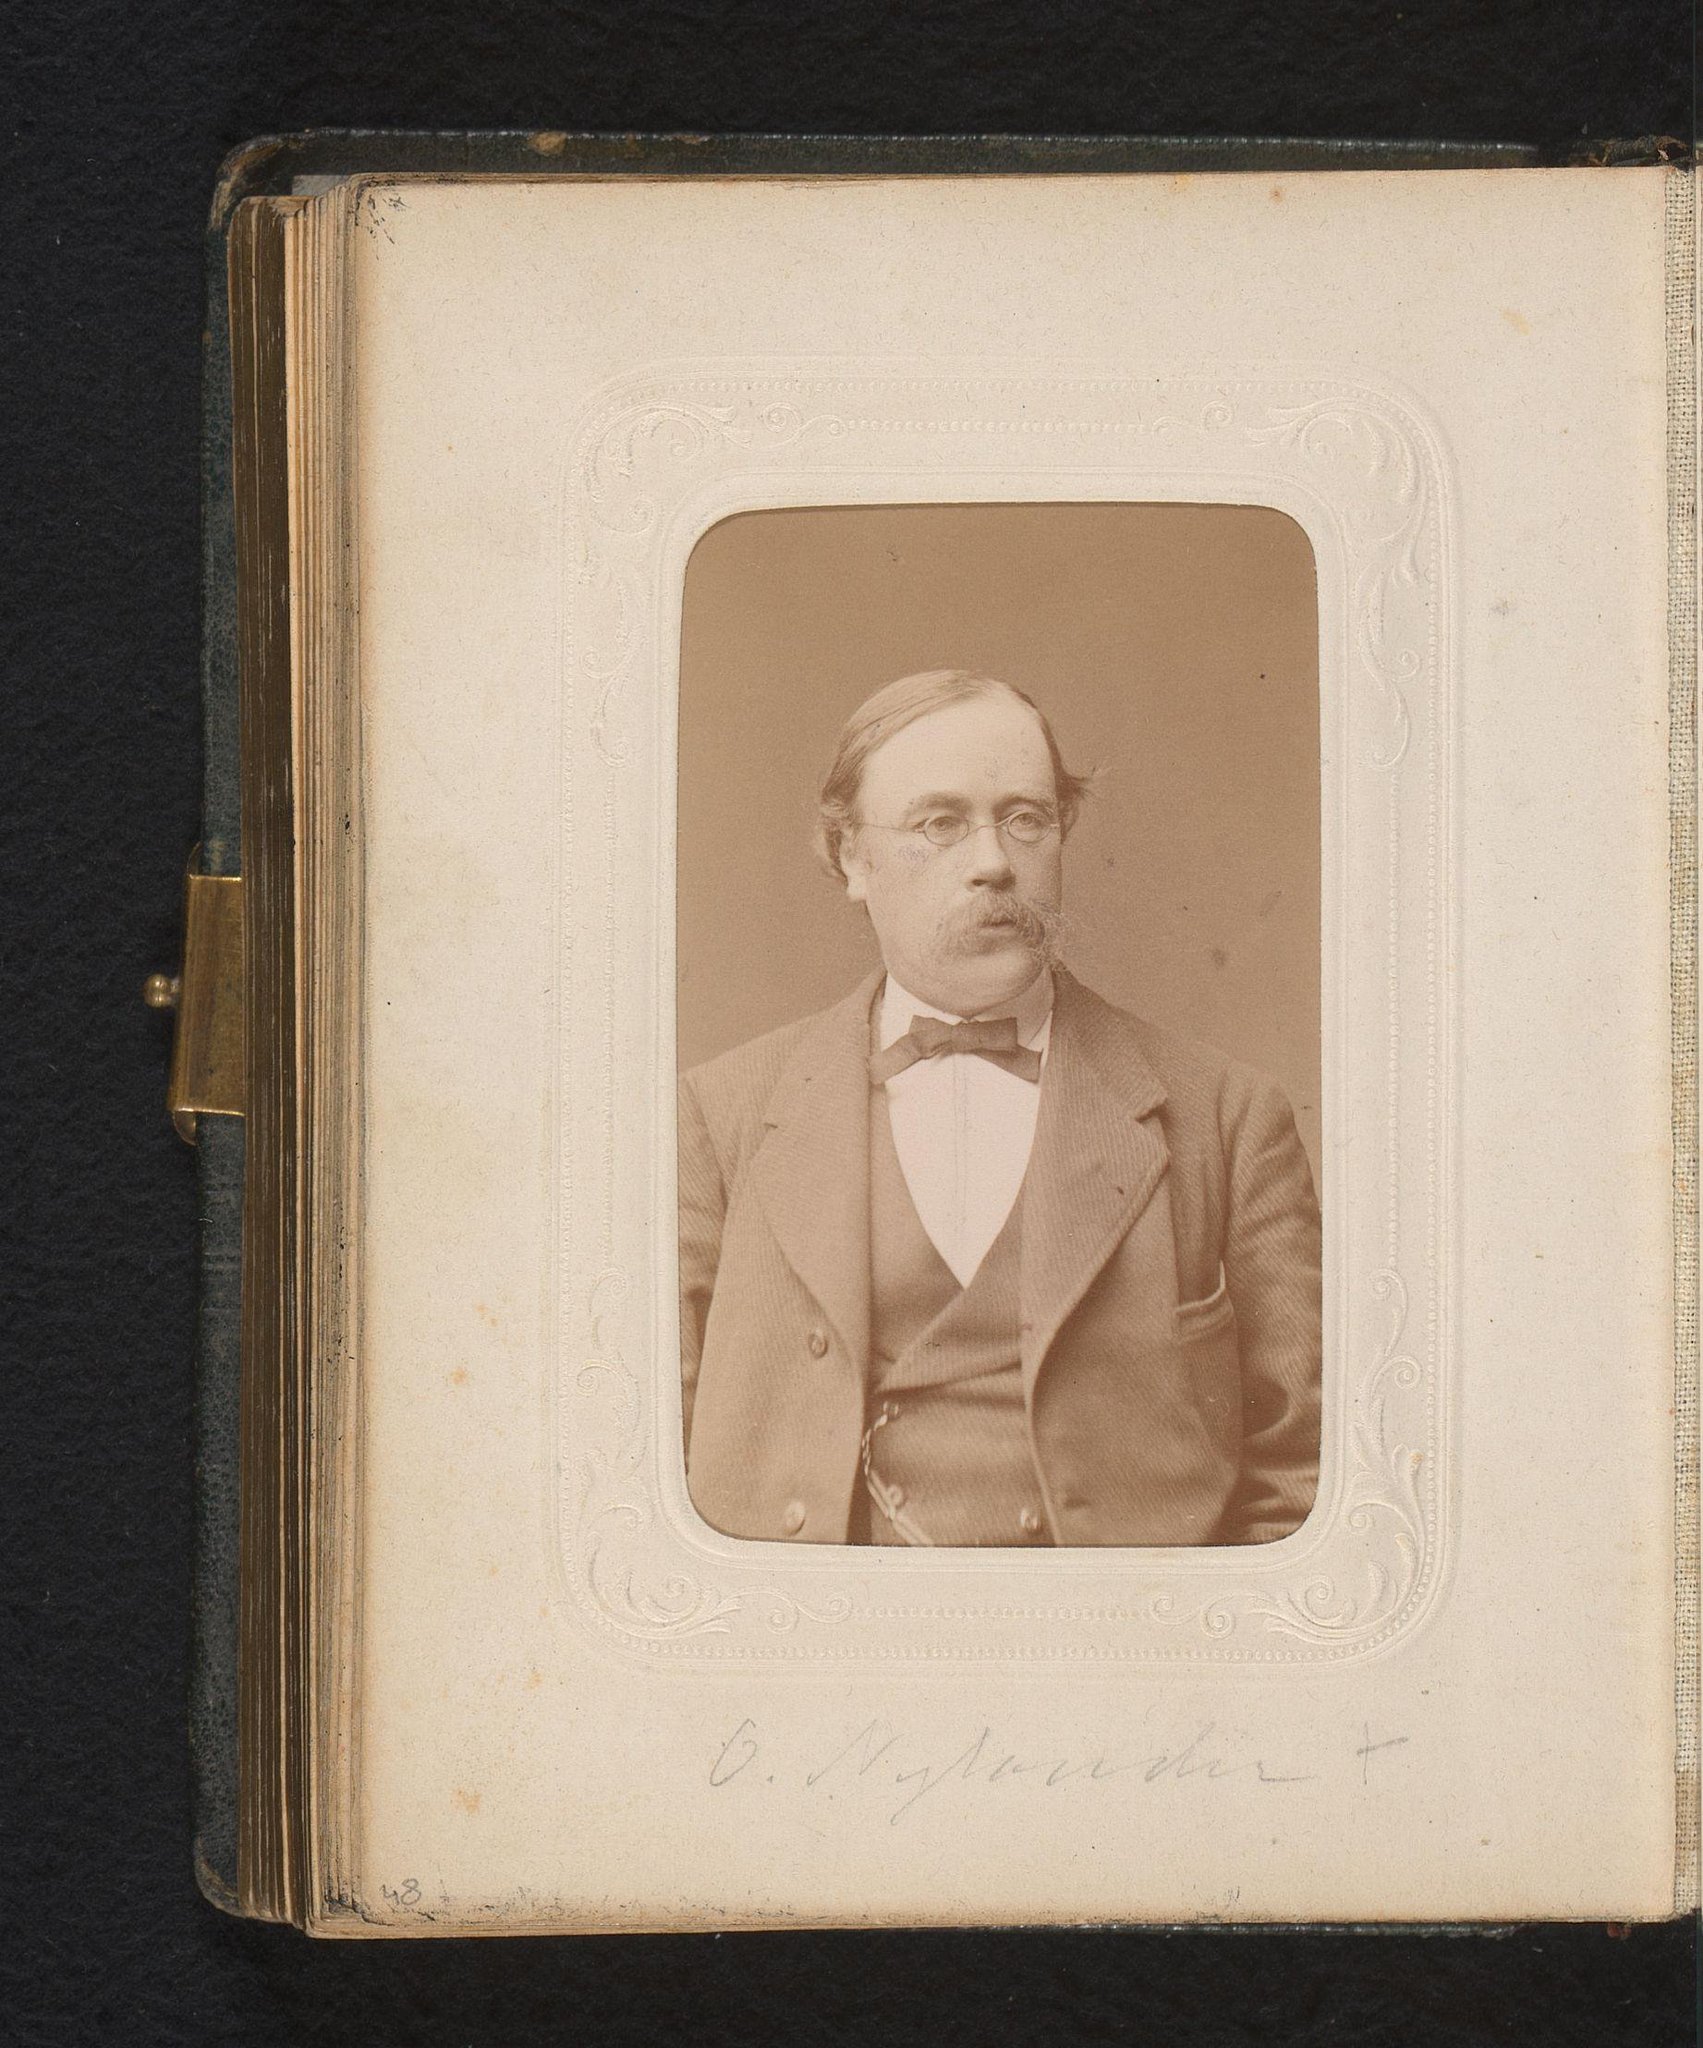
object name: carte de visite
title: Portret van een man met snor en bril, aangeduid als O. Nylander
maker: waldemar dahllöf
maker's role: fotograaf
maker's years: 1844-1935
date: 1860-1900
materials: cardboard, photographic support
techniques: albumen print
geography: göteborg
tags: eyeglasses, spectacles, moustache, historical persons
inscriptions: inscription: ‘WALD. DAHLLOF/ Fotografi Atelier/ GÖTEBORG/ Östra Hamngatan 18./ Plåten behälles för efterbeställning.’